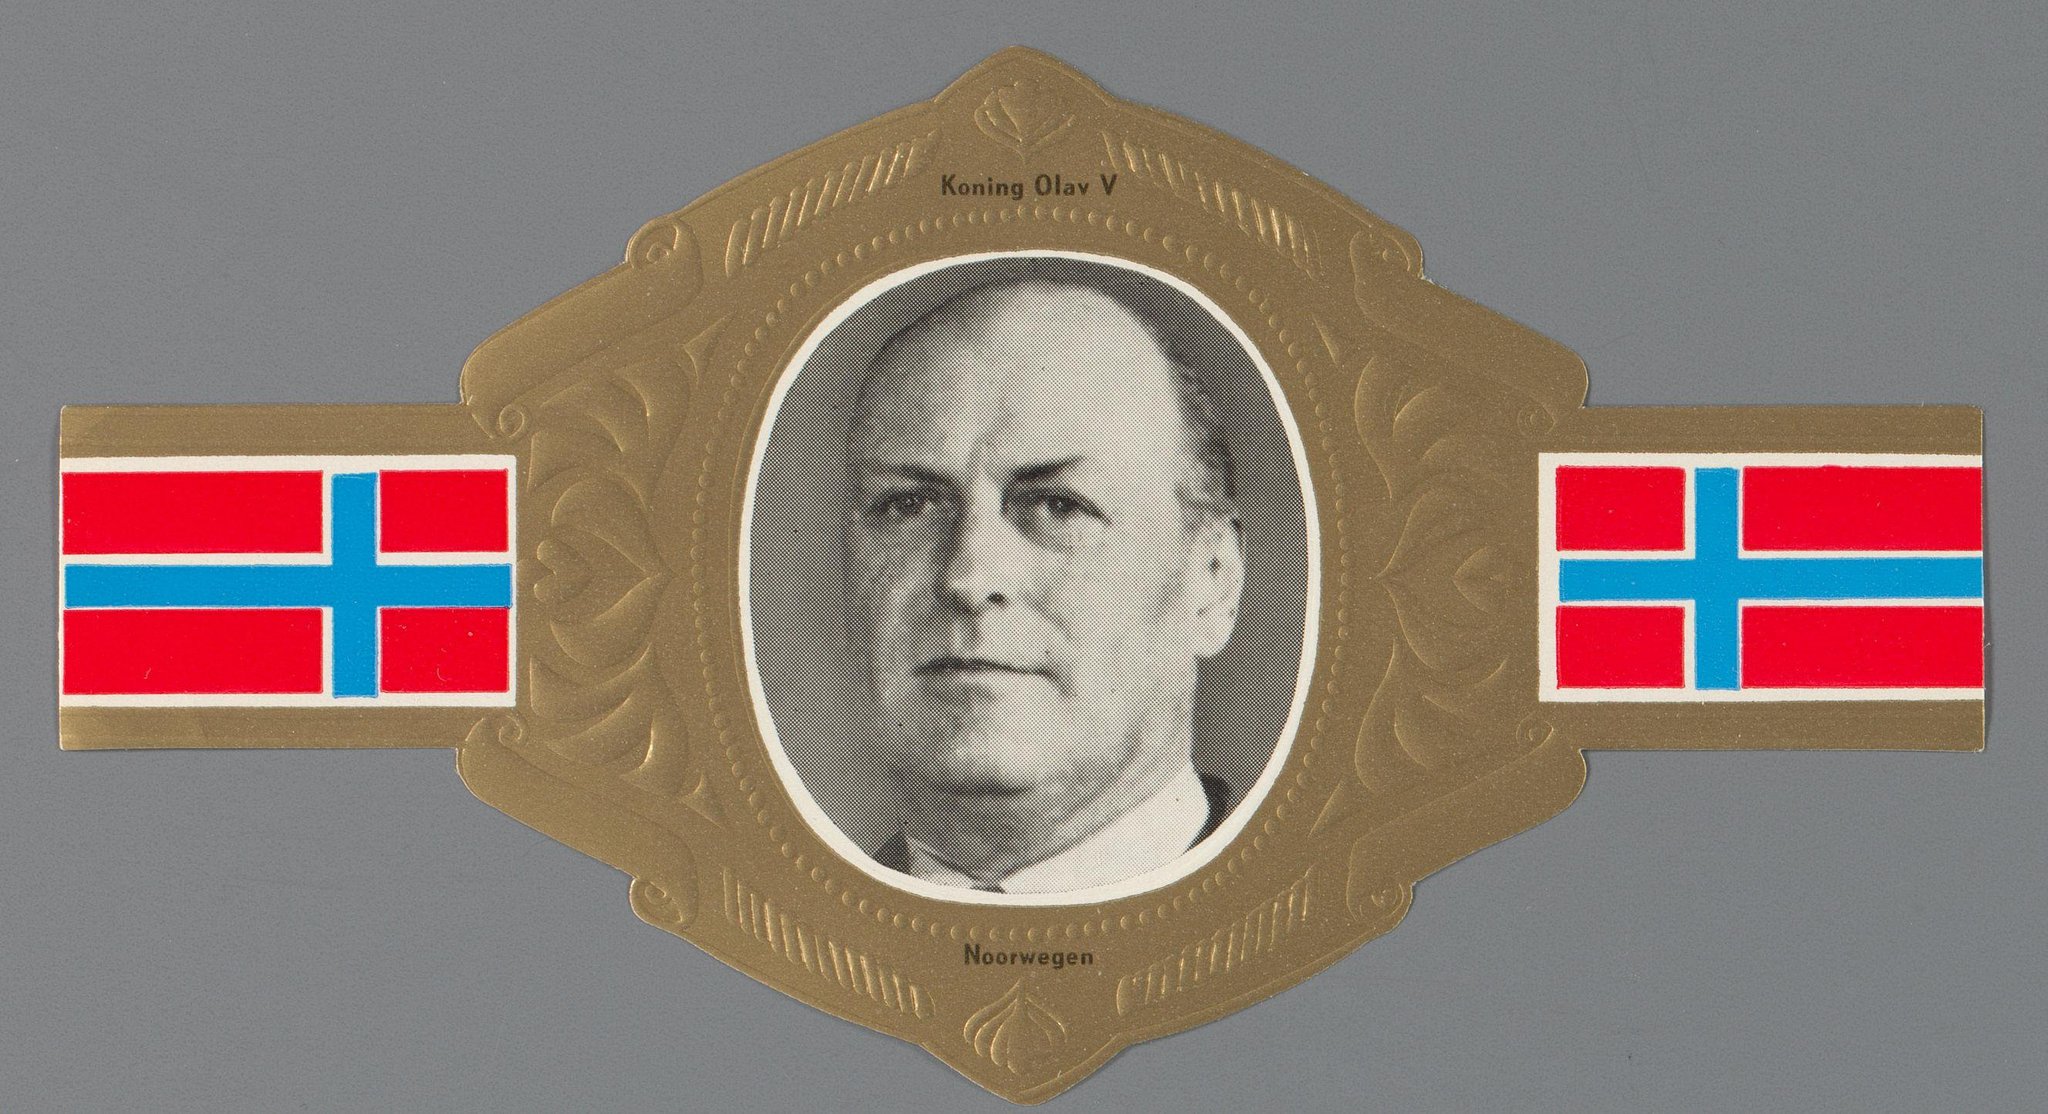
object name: photomechanical print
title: Portret van koning Olaf V van Noorwegen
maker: Anonymous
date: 1961-1963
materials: paper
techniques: blind stamped, printing block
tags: historical persons, king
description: Aan weerszijden van het portret is tweemaal de vlag van het land afgebeeld.